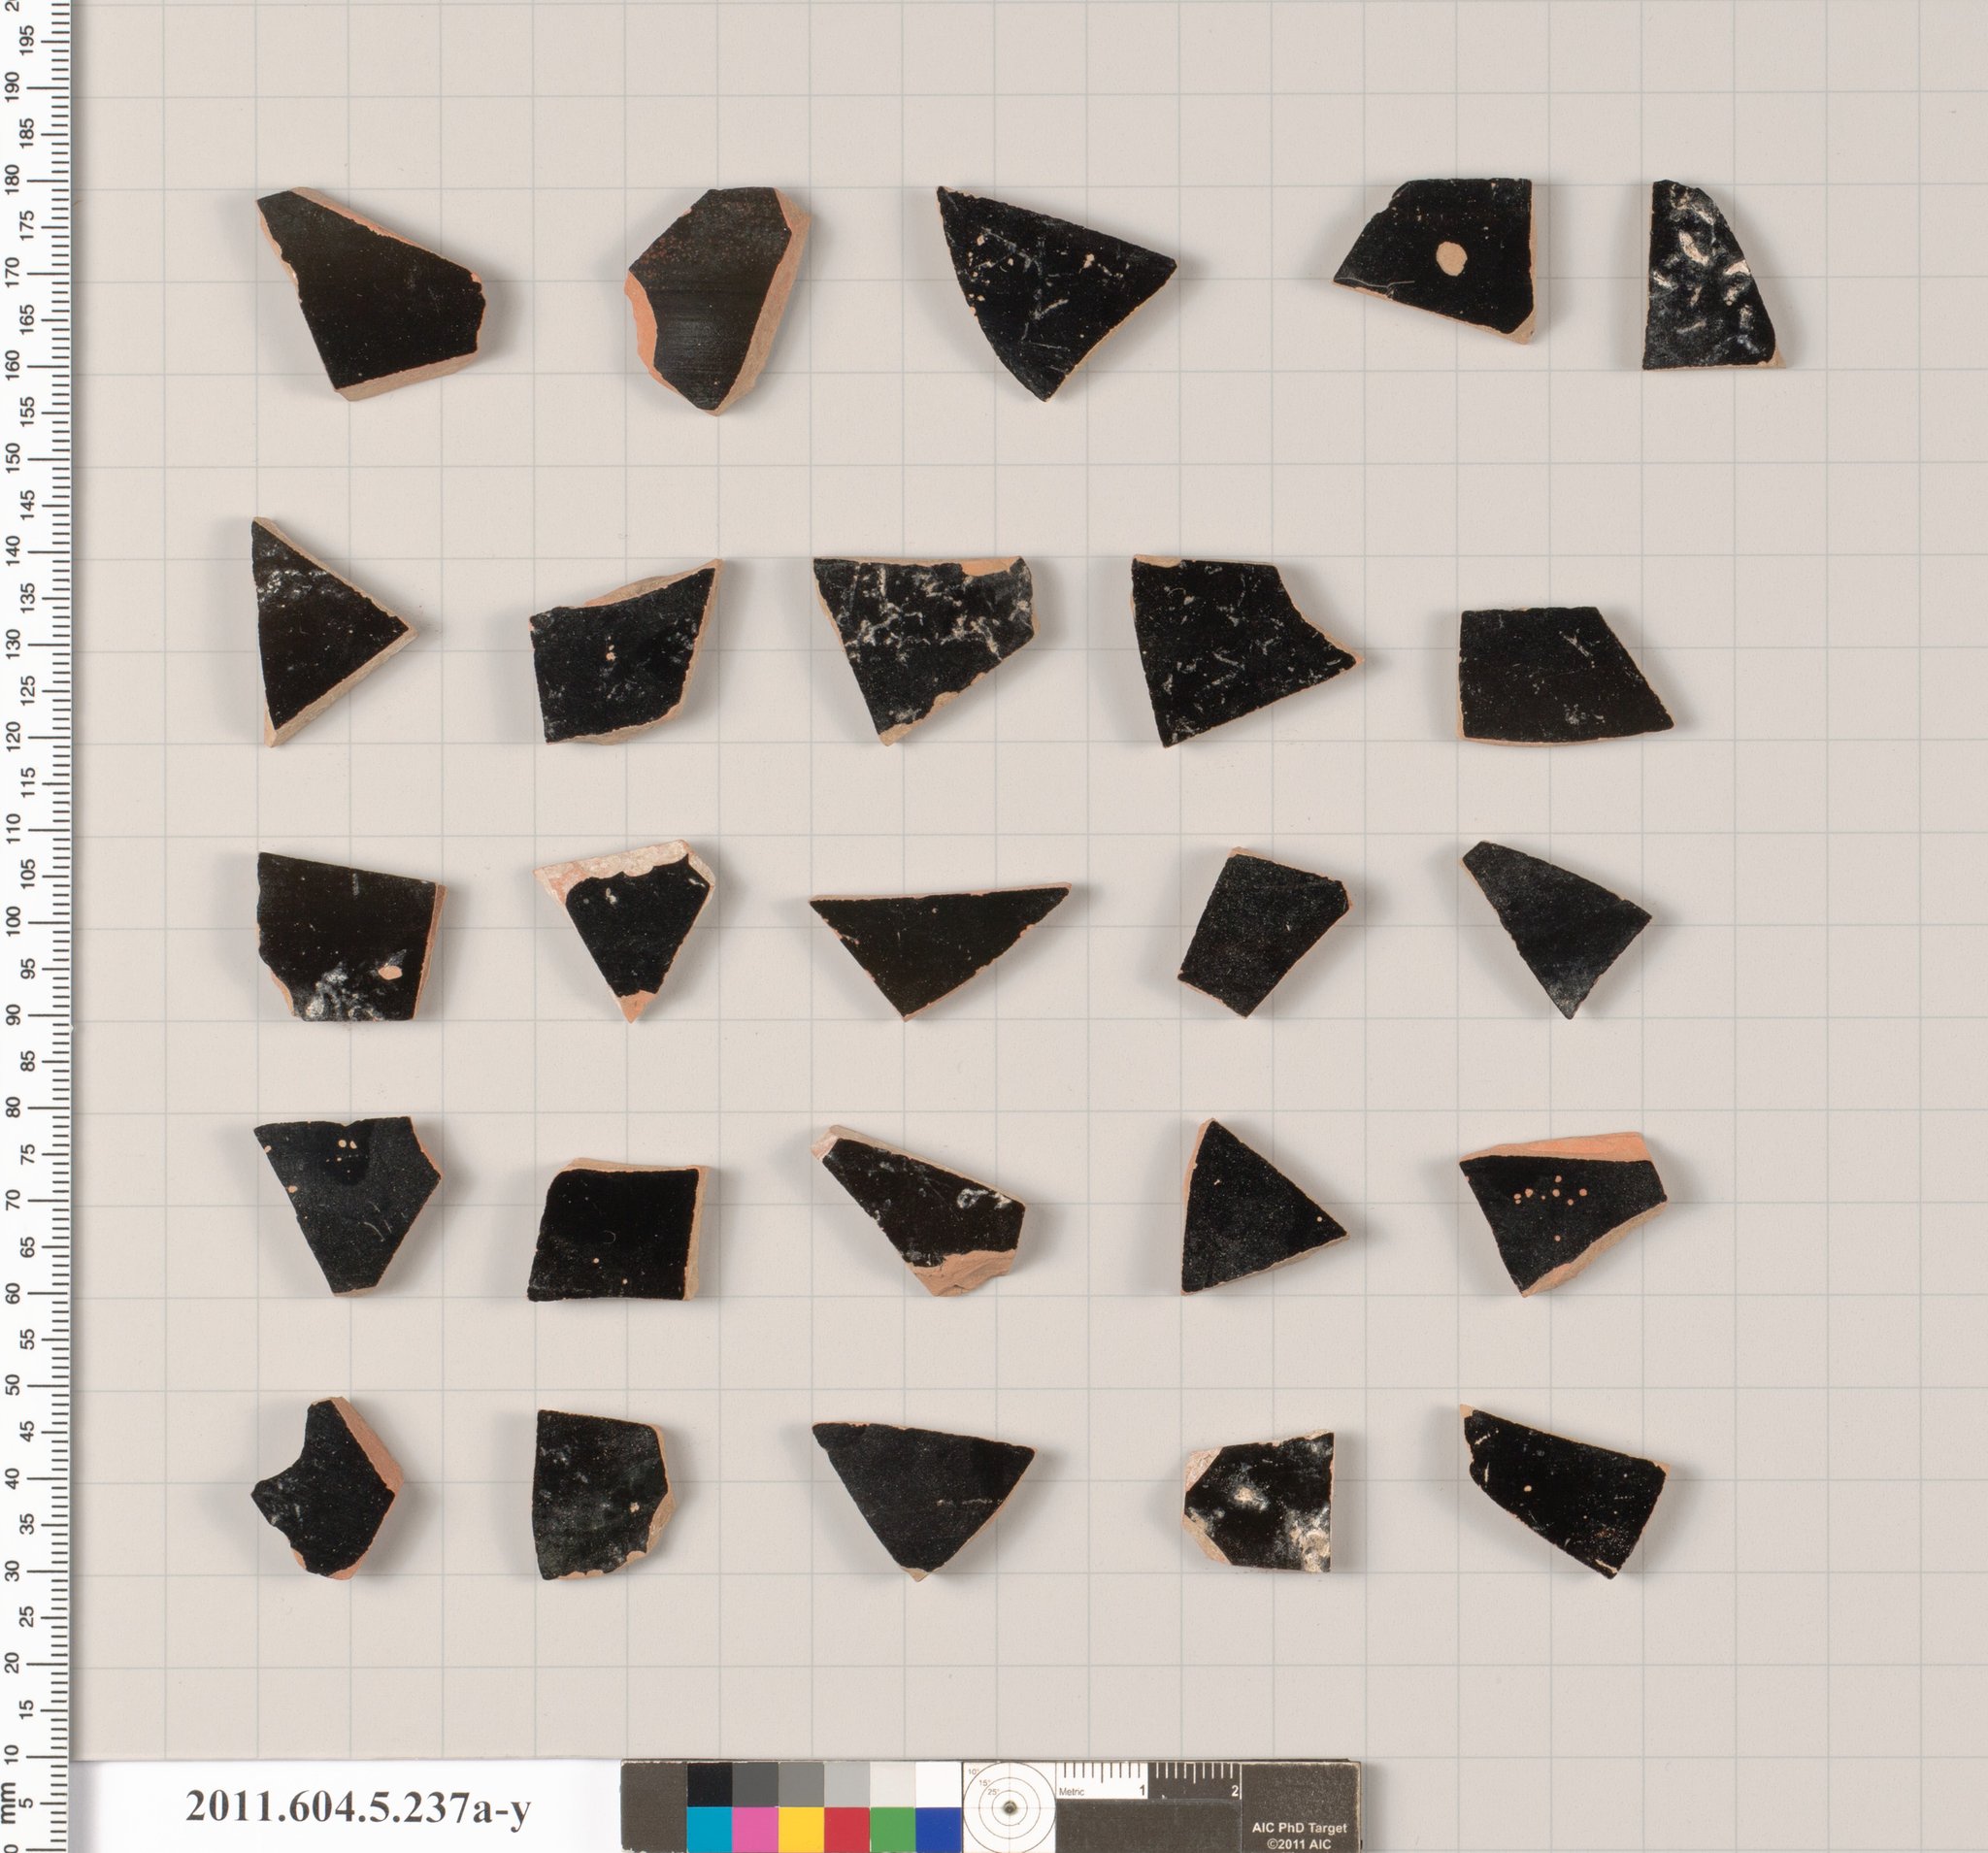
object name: kylix fragment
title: Terracotta fragments of kylikes (drinking cups)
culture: greek, attic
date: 600-401 BCE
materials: terracotta